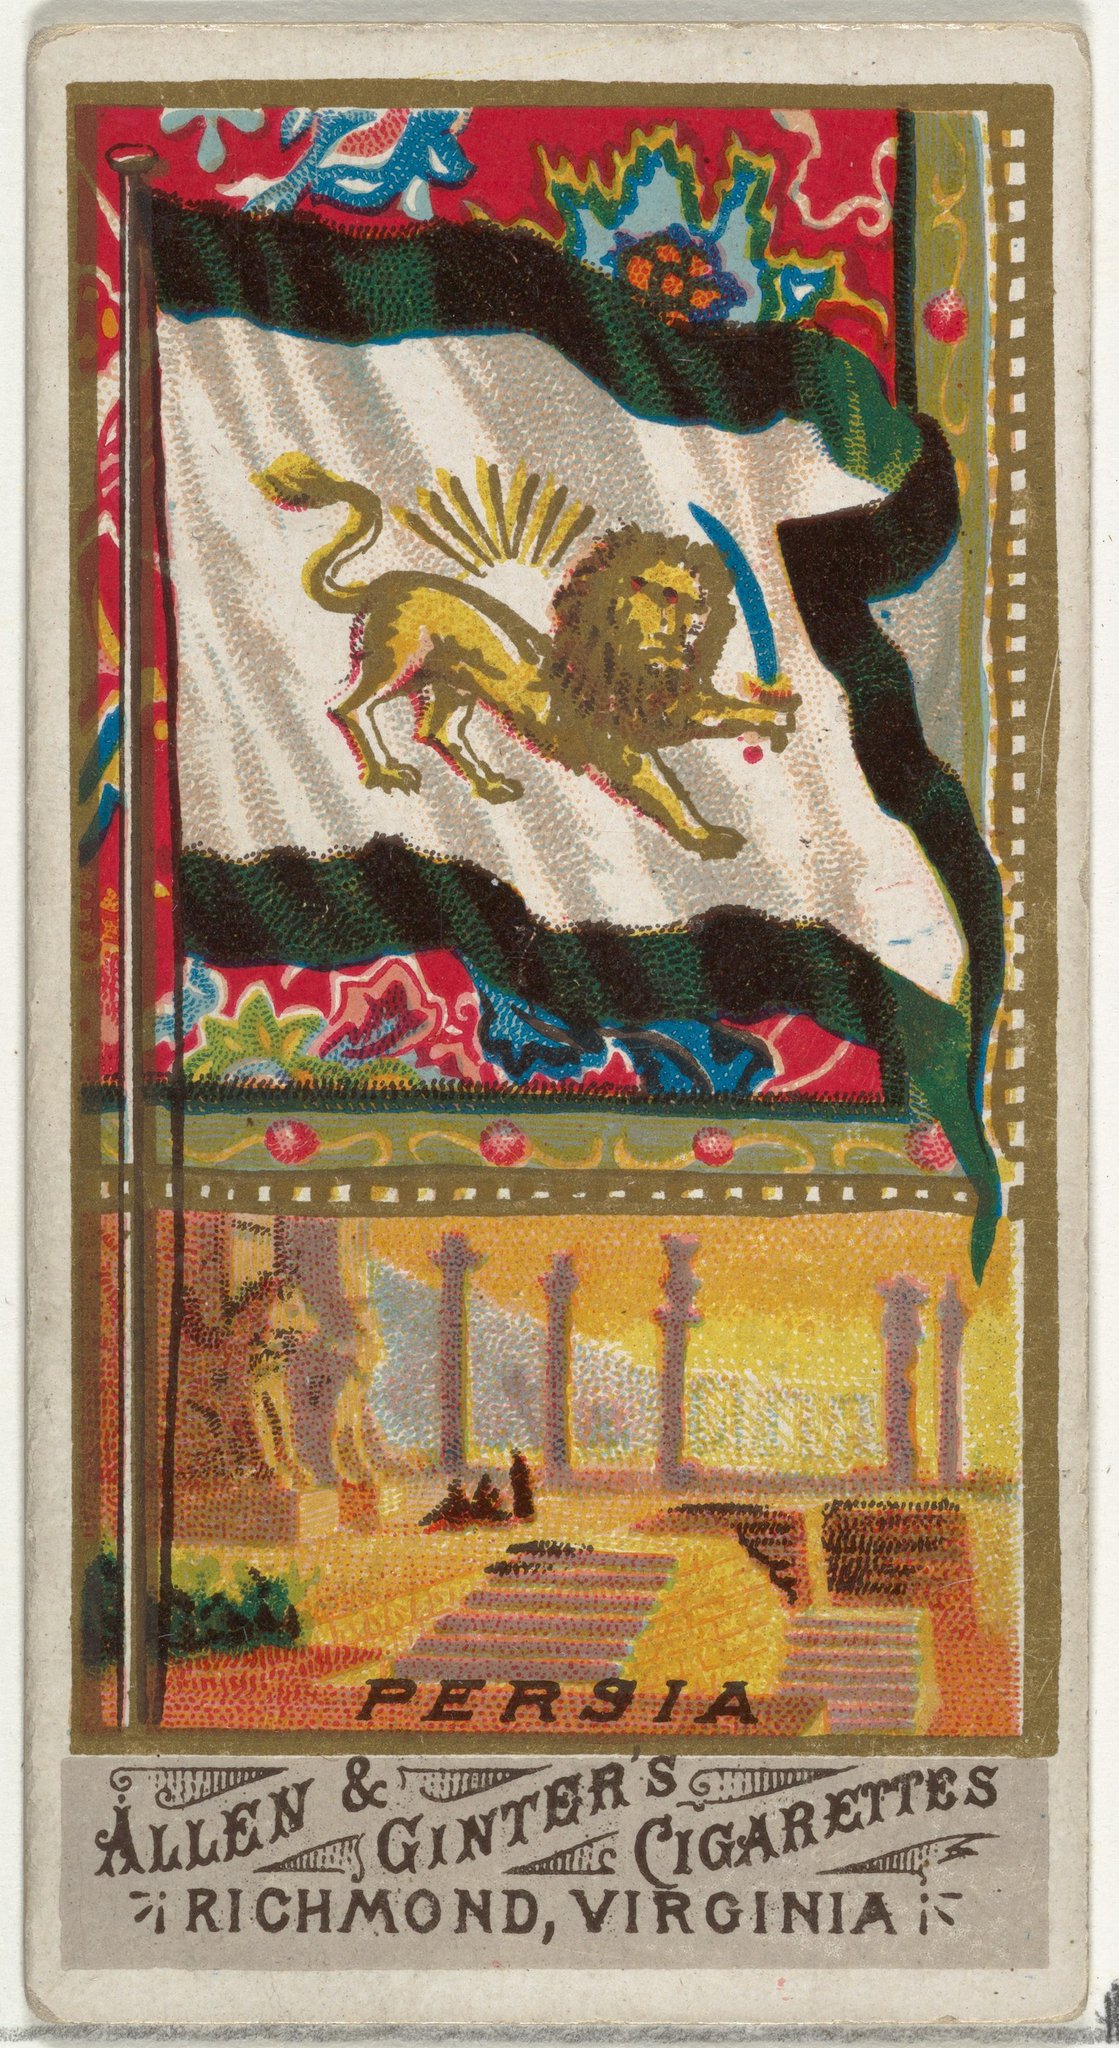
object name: print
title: Persia, from Flags of All Nations, Series 1 (N9) for Allen & Ginter Cigarettes Brands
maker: allen & ginter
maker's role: publisher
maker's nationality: american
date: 1887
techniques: color lithograph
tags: lions,flags